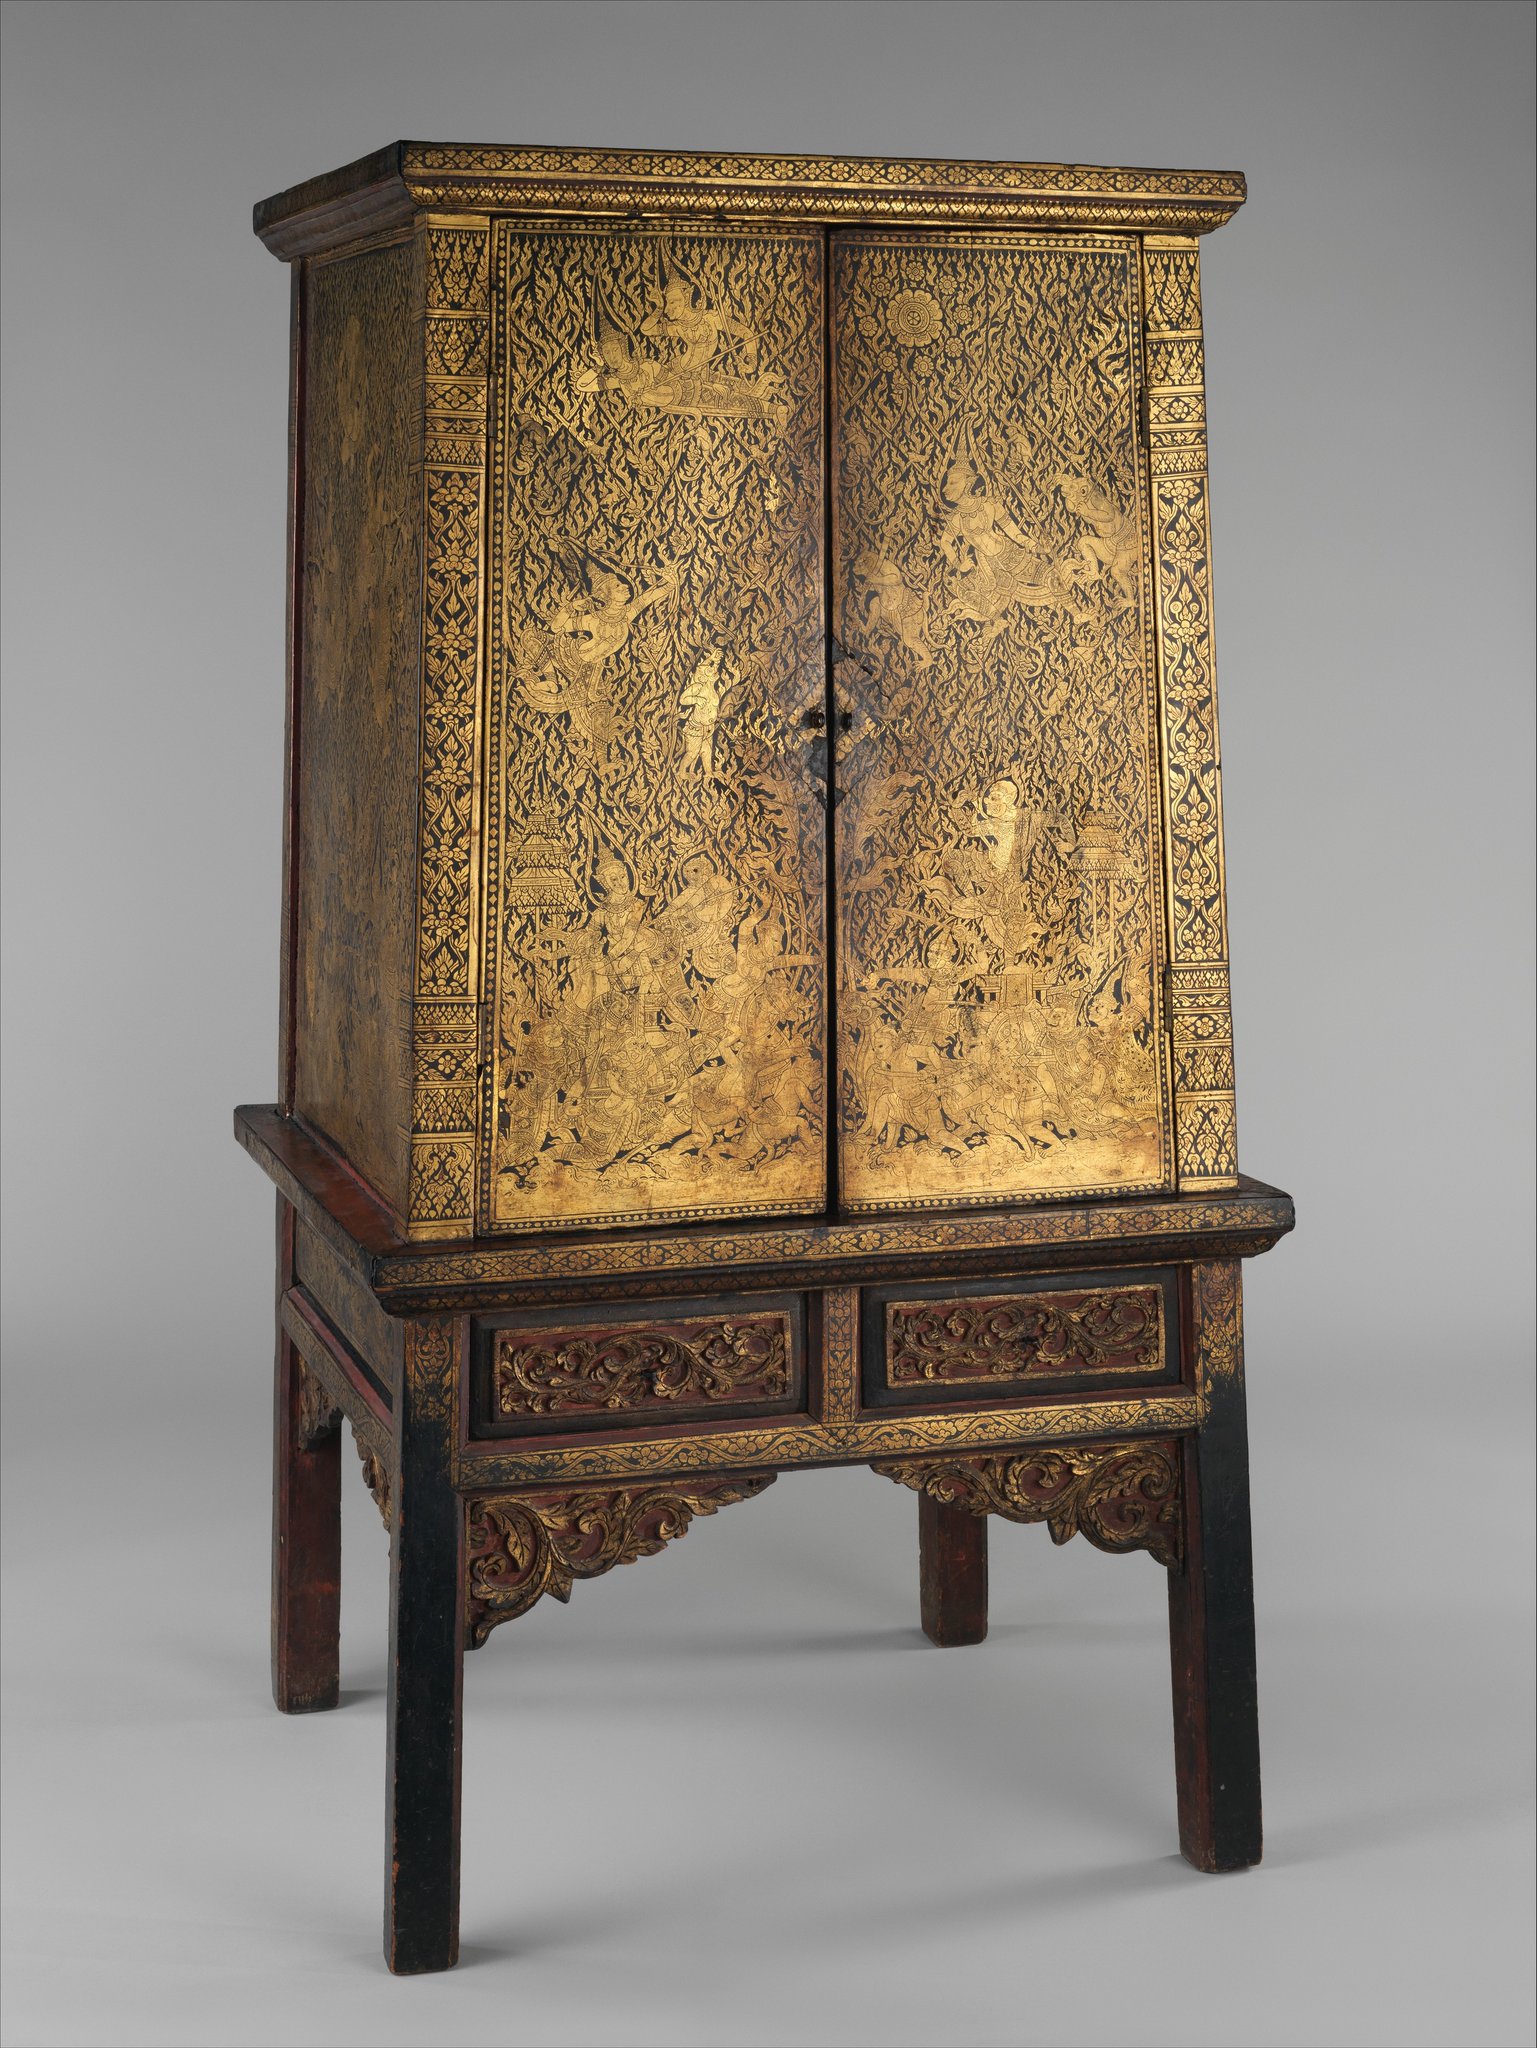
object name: manuscript storage cabinet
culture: thai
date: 1767-1833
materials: gold, lacquer, wood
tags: cabinets